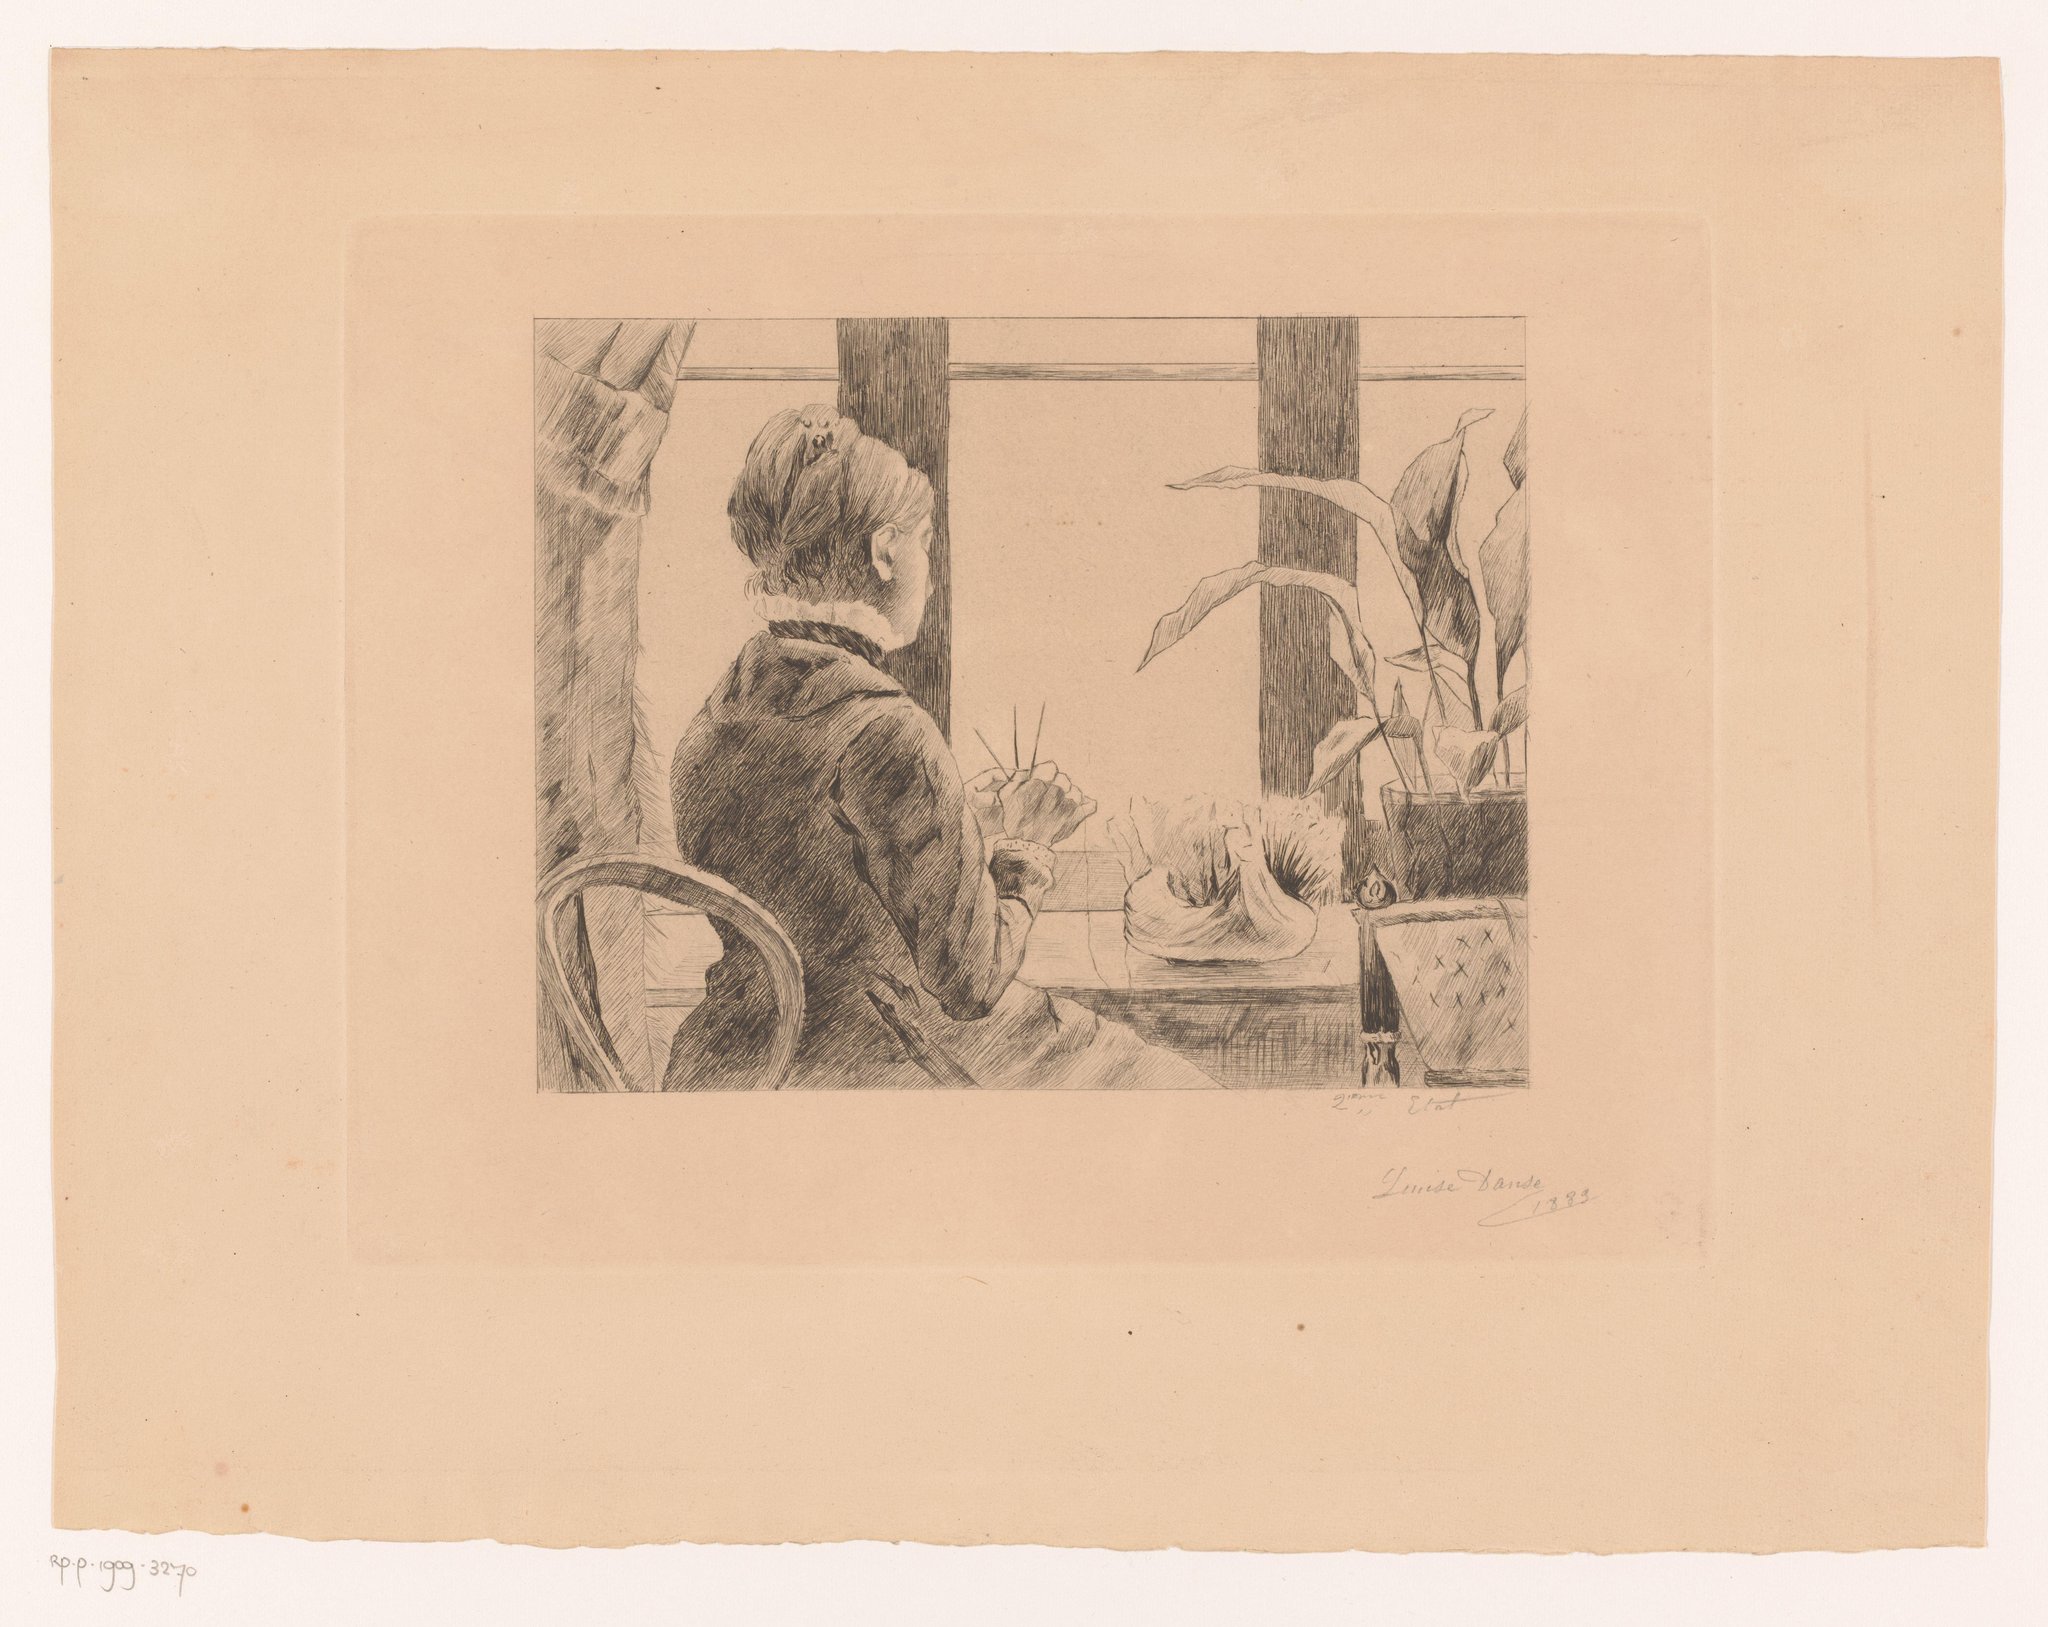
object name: print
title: Handwerkende dame bij het raam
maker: louise danse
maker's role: painter, print maker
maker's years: 1867-1948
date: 1883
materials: paper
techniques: etching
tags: (other forms of) needlework, e.g.: crocheting, knitting, embroidering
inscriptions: collector's mark: Lugt 2228, annotation: ‘2eme Etat’